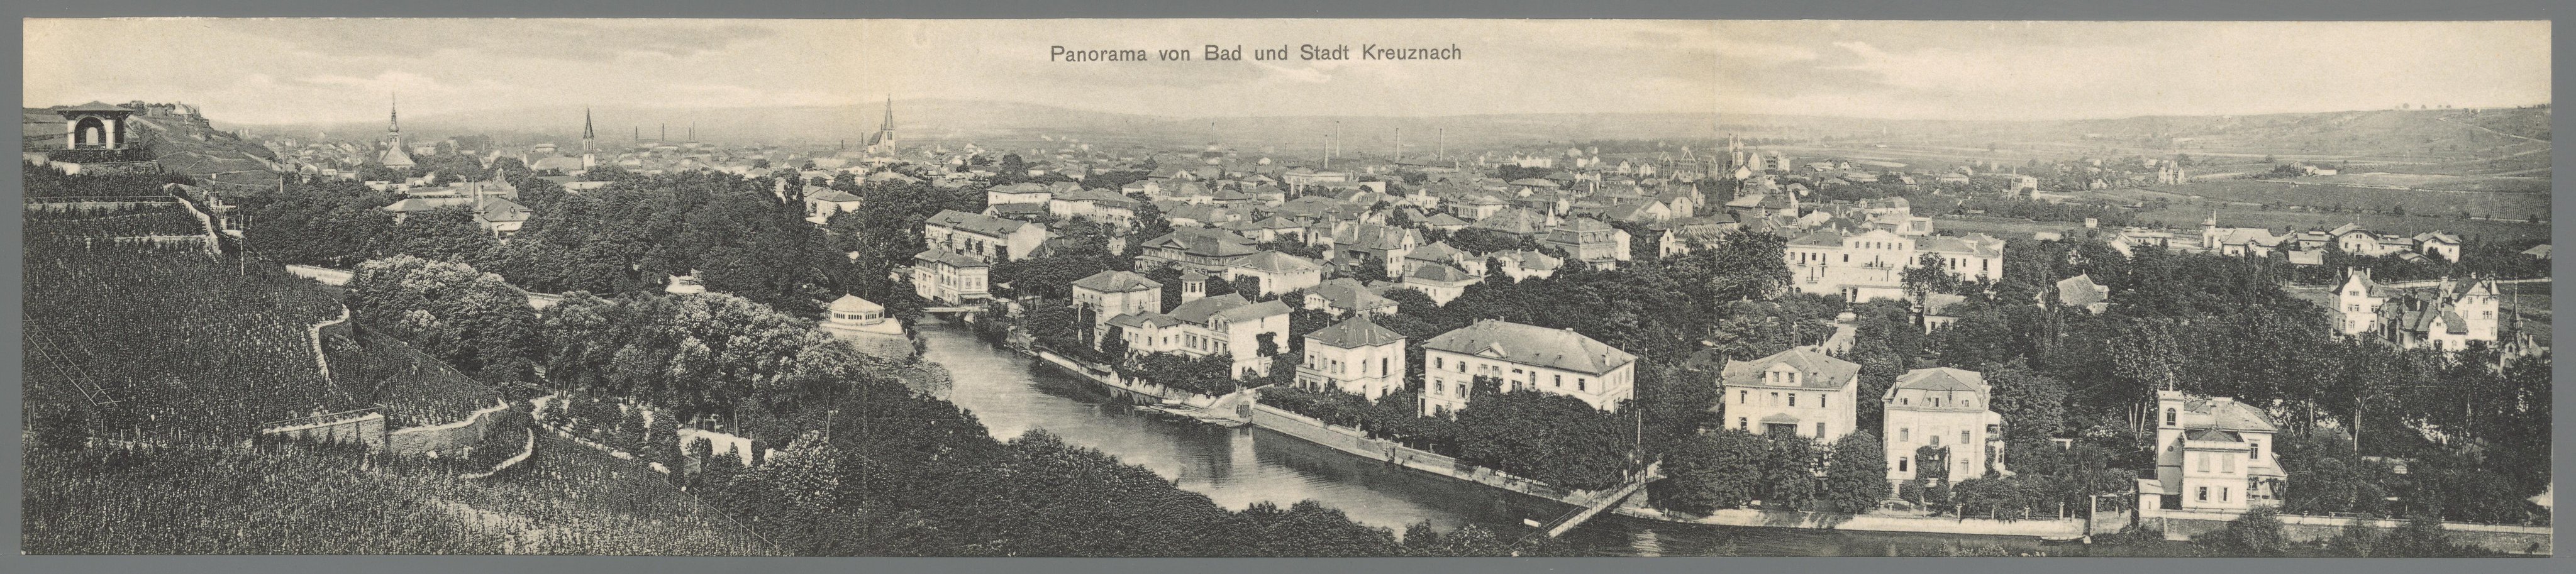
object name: photomechanical print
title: Panorama von Bad und Stadt Kreuznach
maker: Anonymous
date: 1907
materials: cardboard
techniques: photograph, writing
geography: bad kreuznach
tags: canals, waters (in city), prospect of city, town panorama, silhouette of city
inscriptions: date